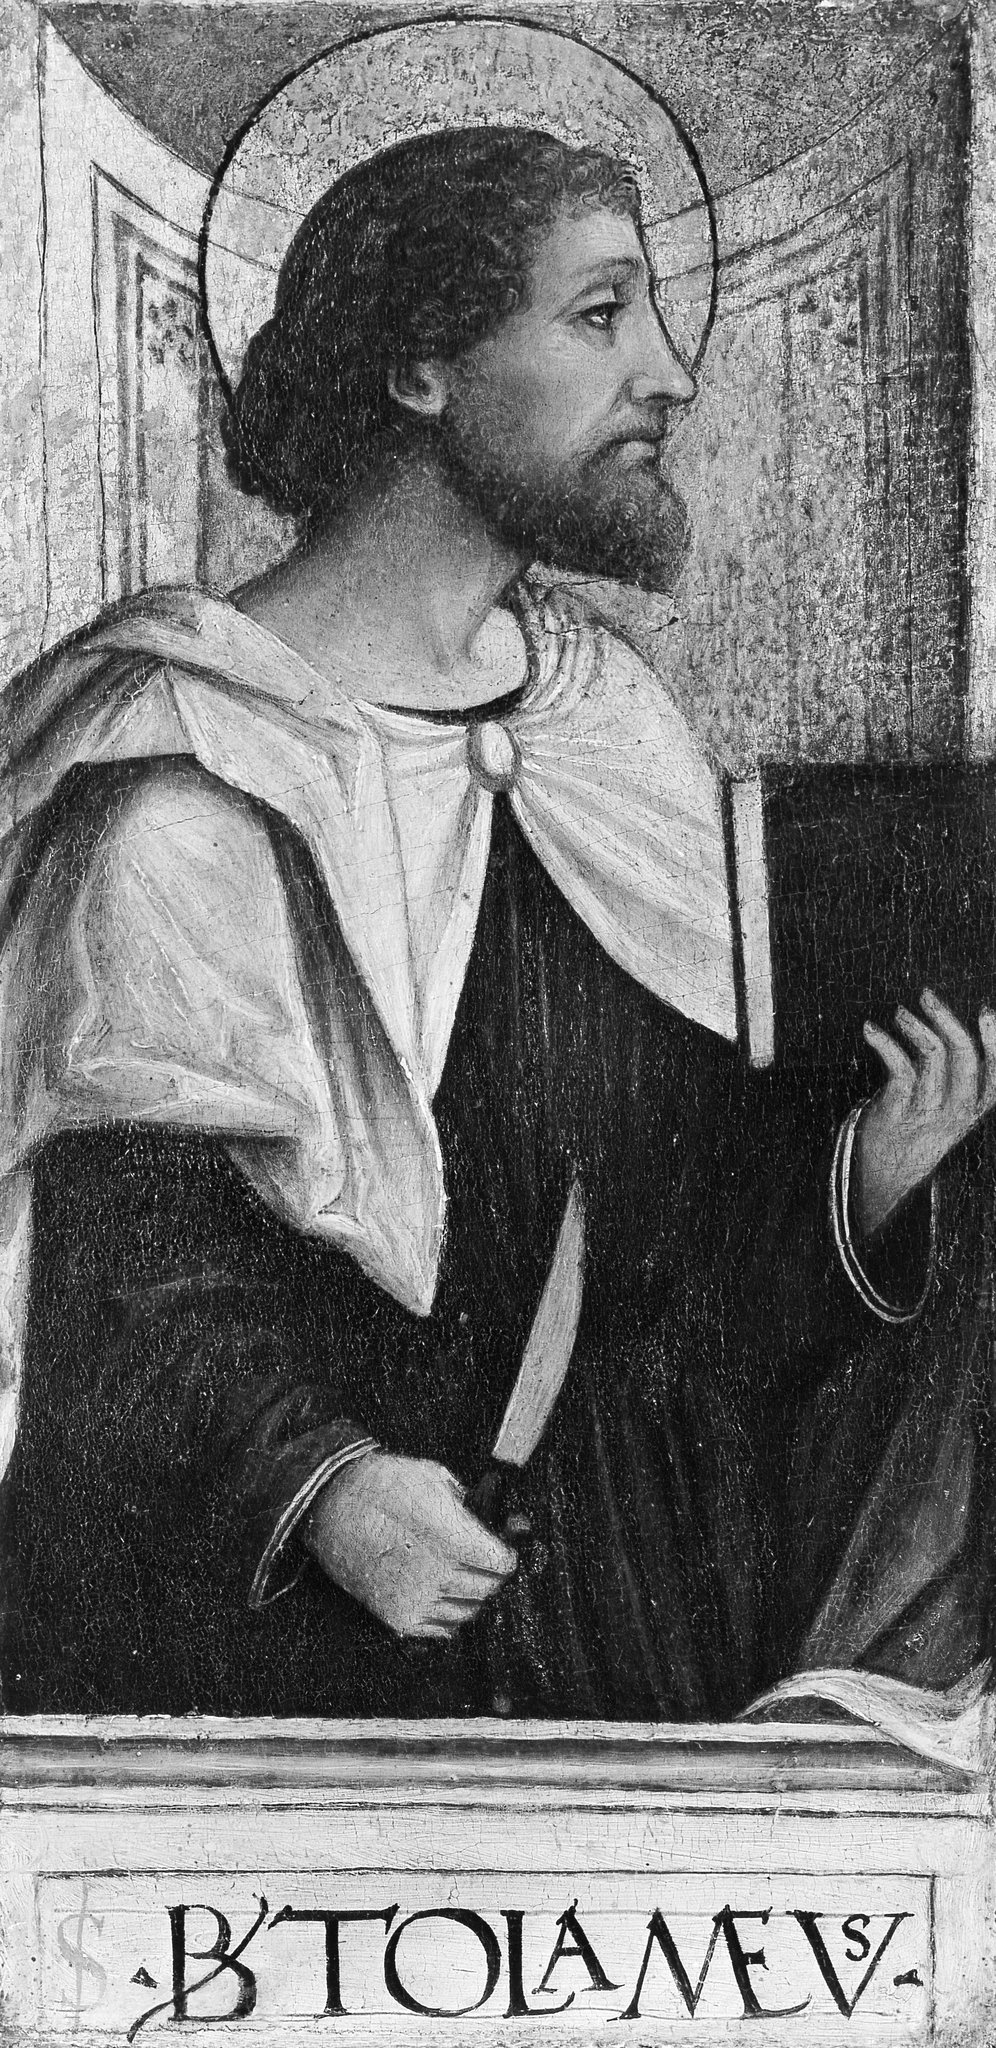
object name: painting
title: The Twelve Apostles: Saints Bartholomew, Andrew, Matthew, James the Greater, Thaddeus, Philip, James the Lesser, Simon, Peter, Paul, Thomas, and John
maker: bergognone (ambrogio di stefano da fossano)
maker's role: artist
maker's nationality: italian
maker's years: 1453-1523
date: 1481-1522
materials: gold, oil, wood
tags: men,apostles,saint matthew,saint paul,saint peter,saints